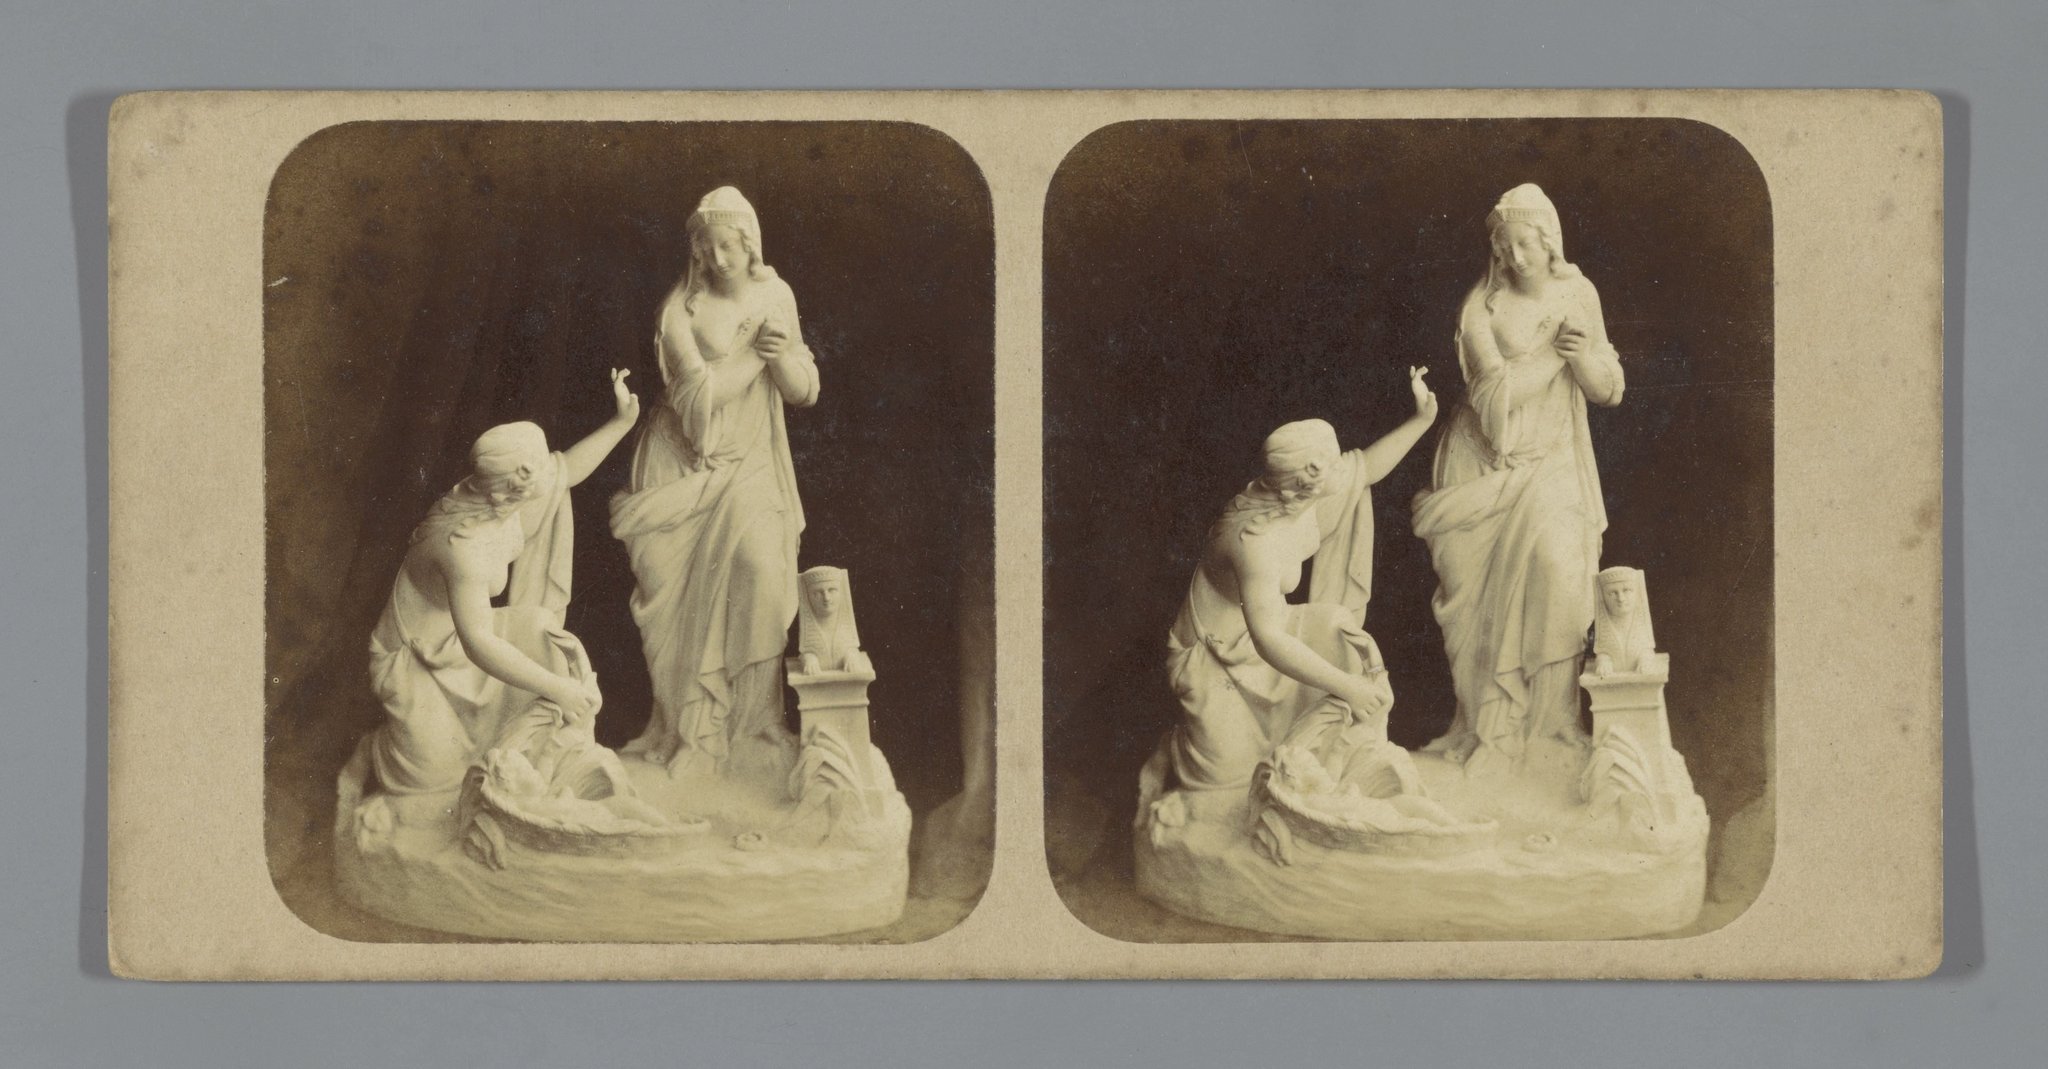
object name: stereograph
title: Sculptuur van twee vrouwen die Mozes in mandje vinden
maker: charles e. goodman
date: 1855-1880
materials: cardboard, photographic support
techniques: albumen print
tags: sculpture, the finding of moses: pharaoh's daughter comes to bathe with her maidens in the river and discovers the child floating on the water